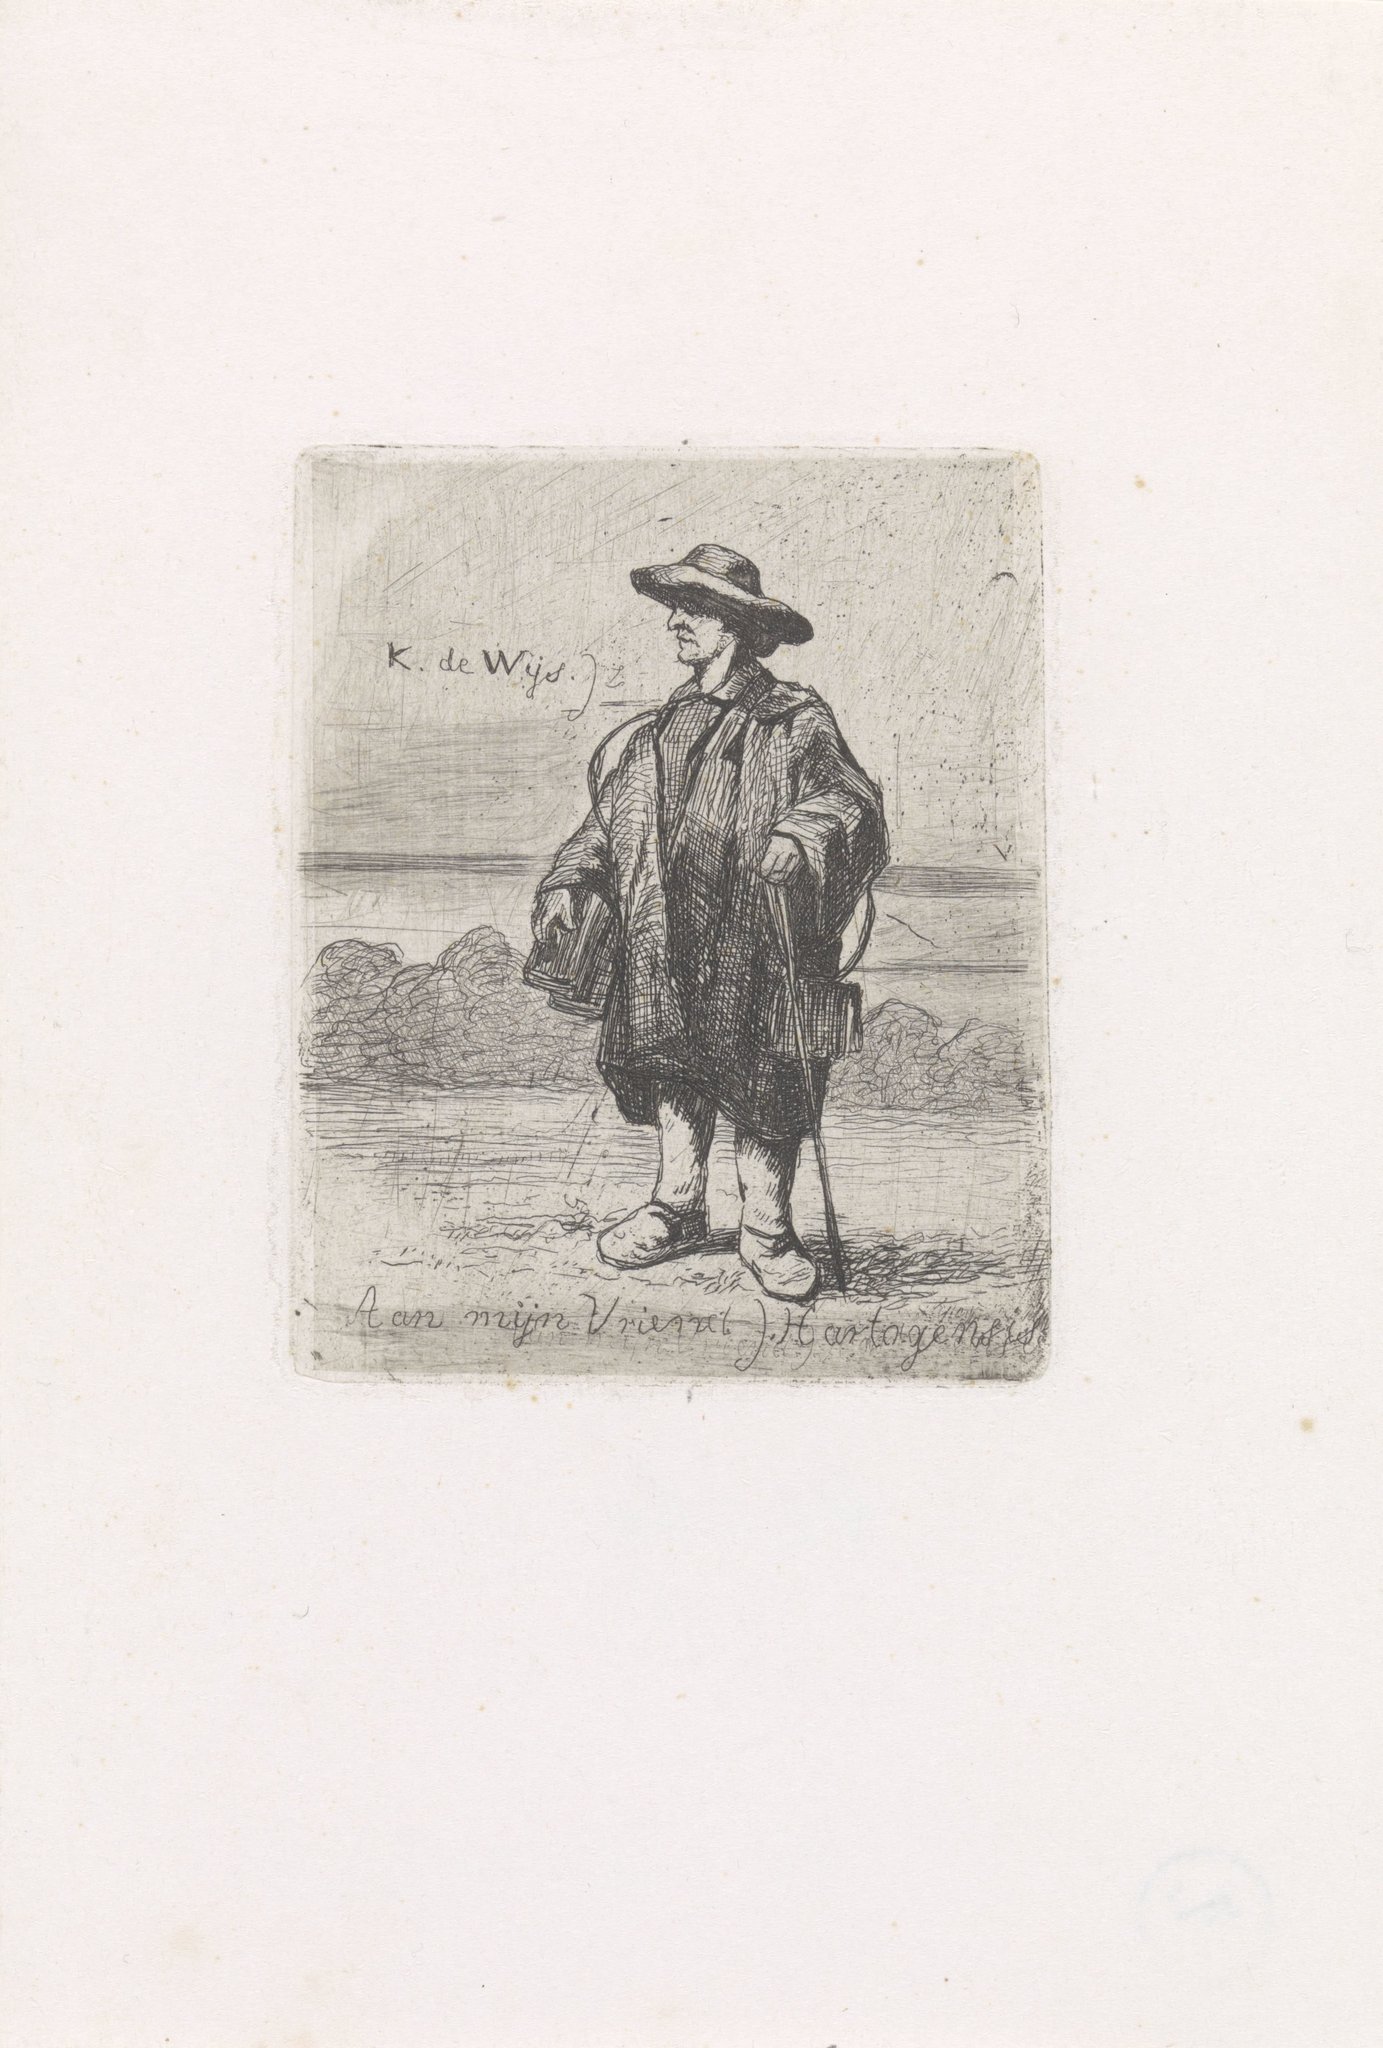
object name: print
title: Man met hoed op het hoofd en stok in de hand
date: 1842-1896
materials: paper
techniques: etching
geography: netherlands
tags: walking-stick, staff, head-gear: hat (+ men's clothes)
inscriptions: collector's mark: Lugt 138, collector's mark: Lugt 2228, collector's mark: Lugt 2760